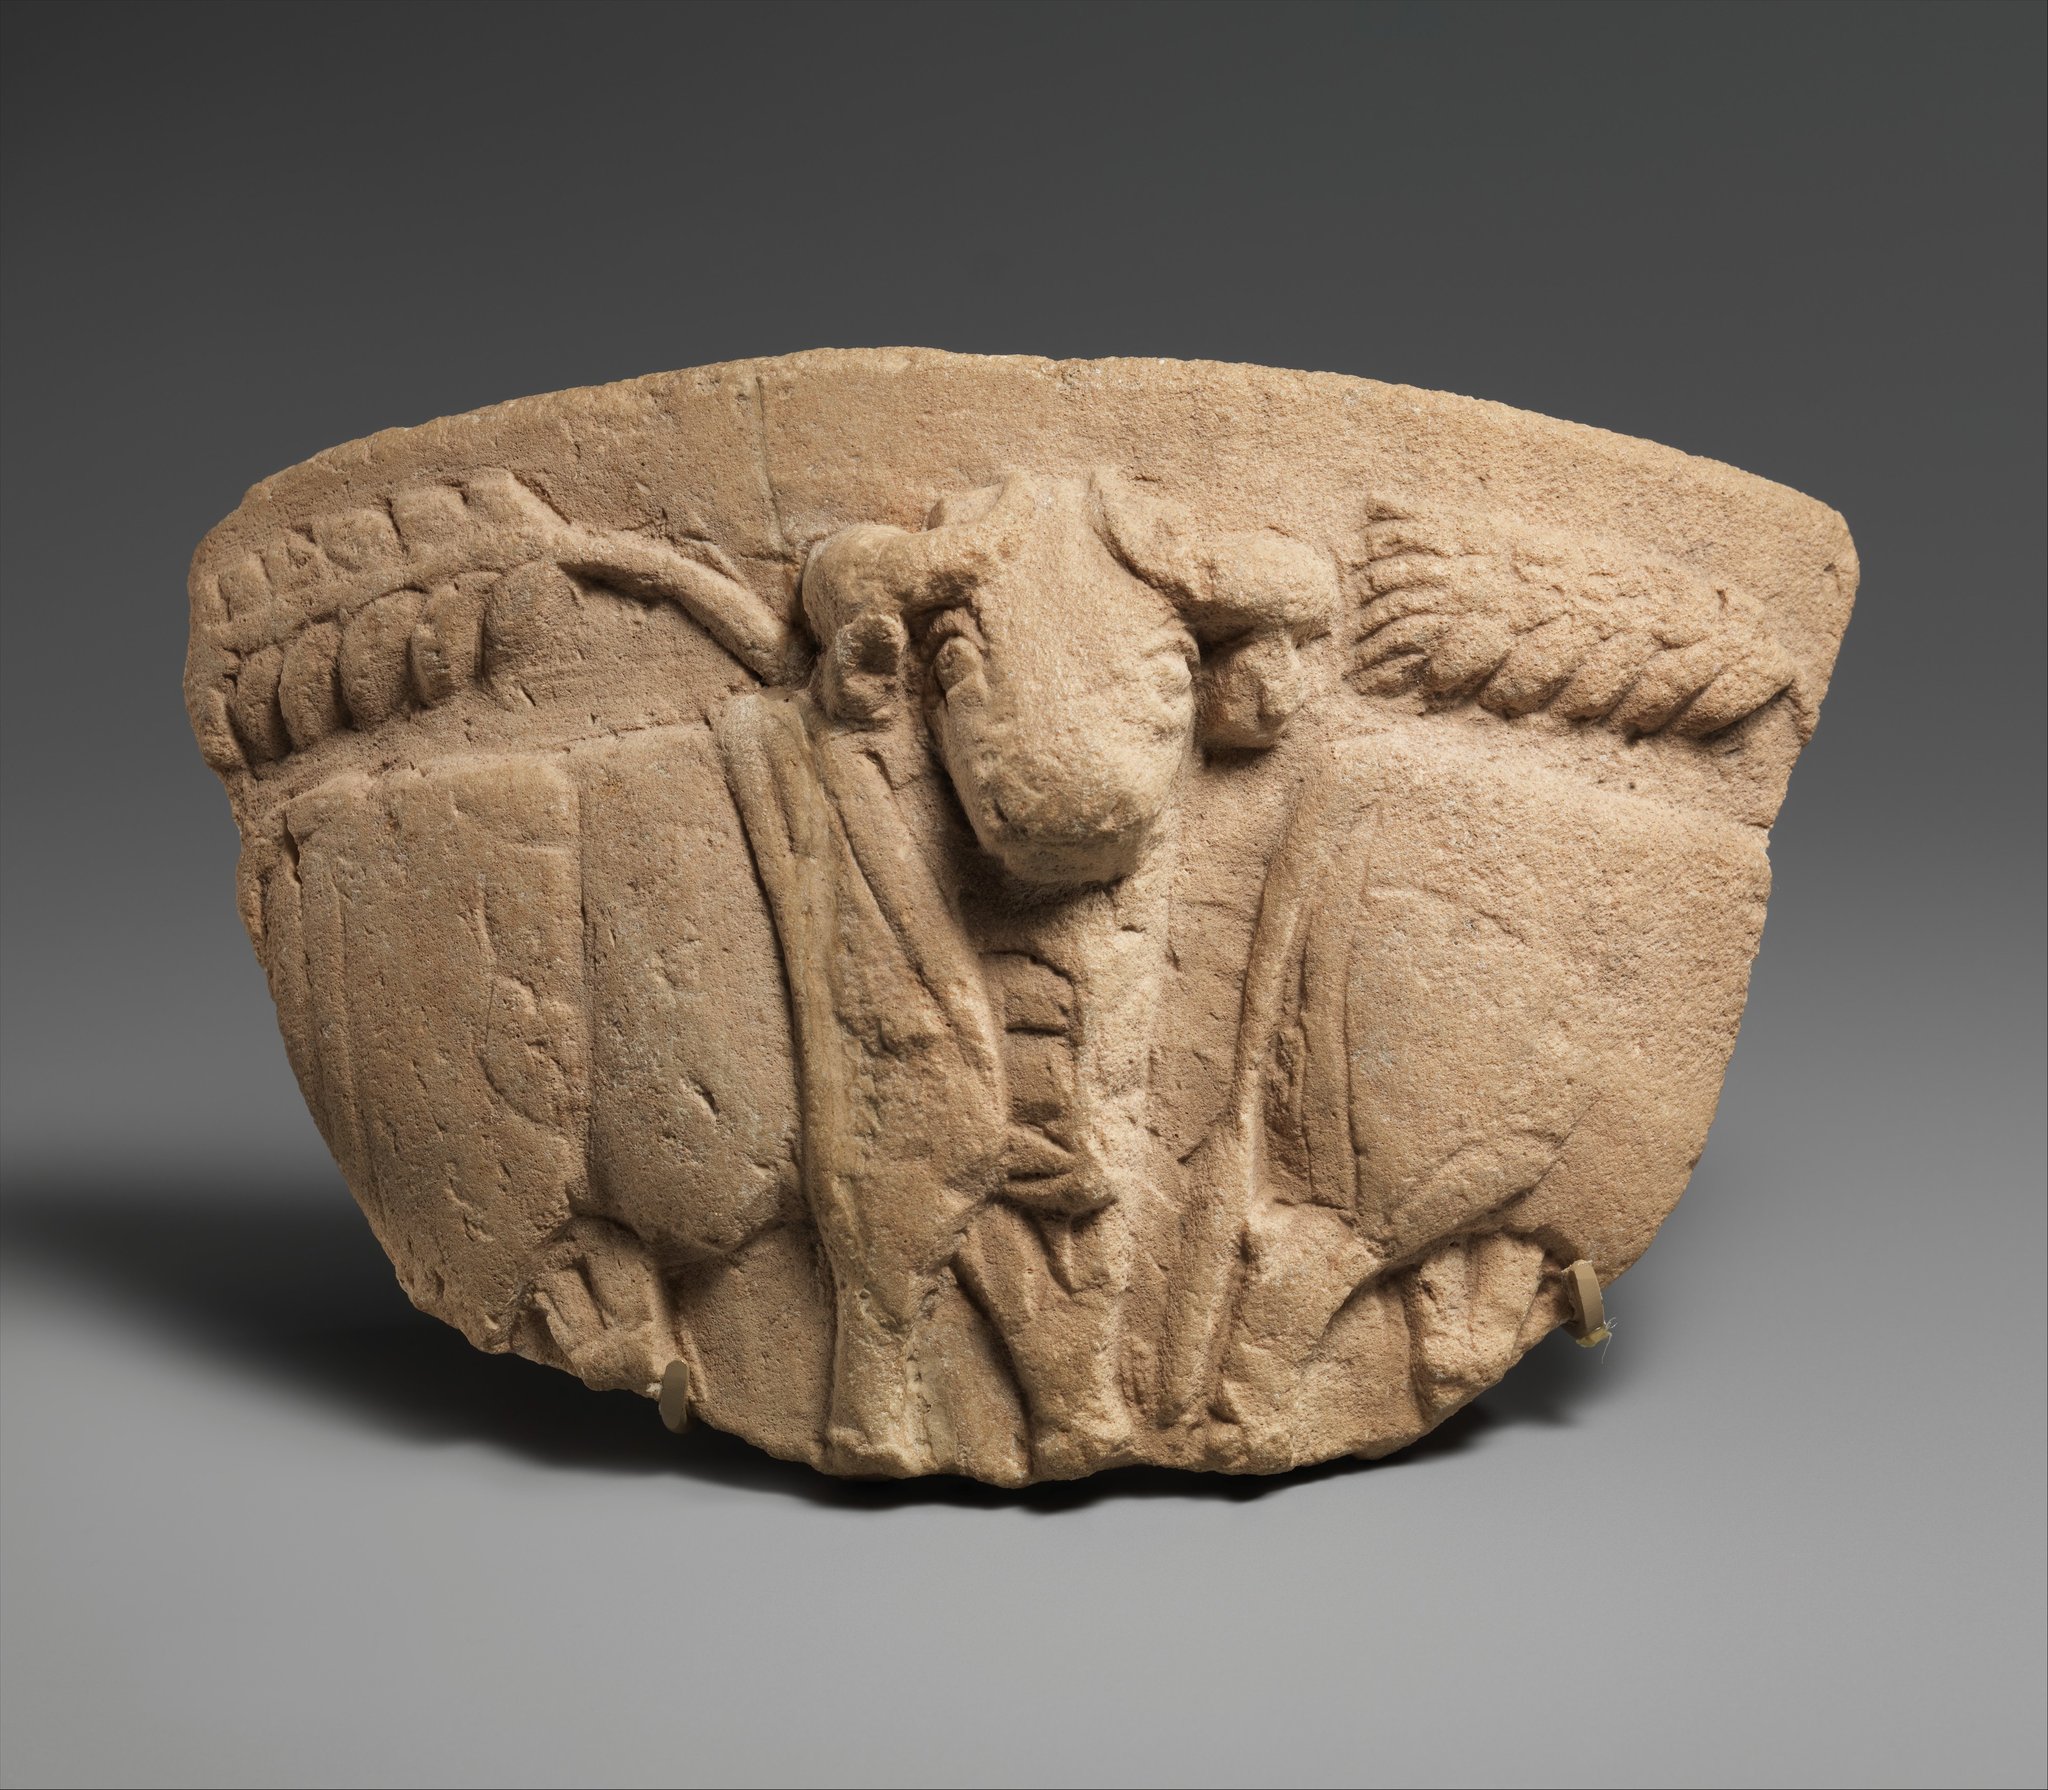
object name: vessel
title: Fragment of a vessel with wheat stalks and a procession of bulls in relief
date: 3300-2900 BCE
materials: limestone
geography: southern mesopotamia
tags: bulls